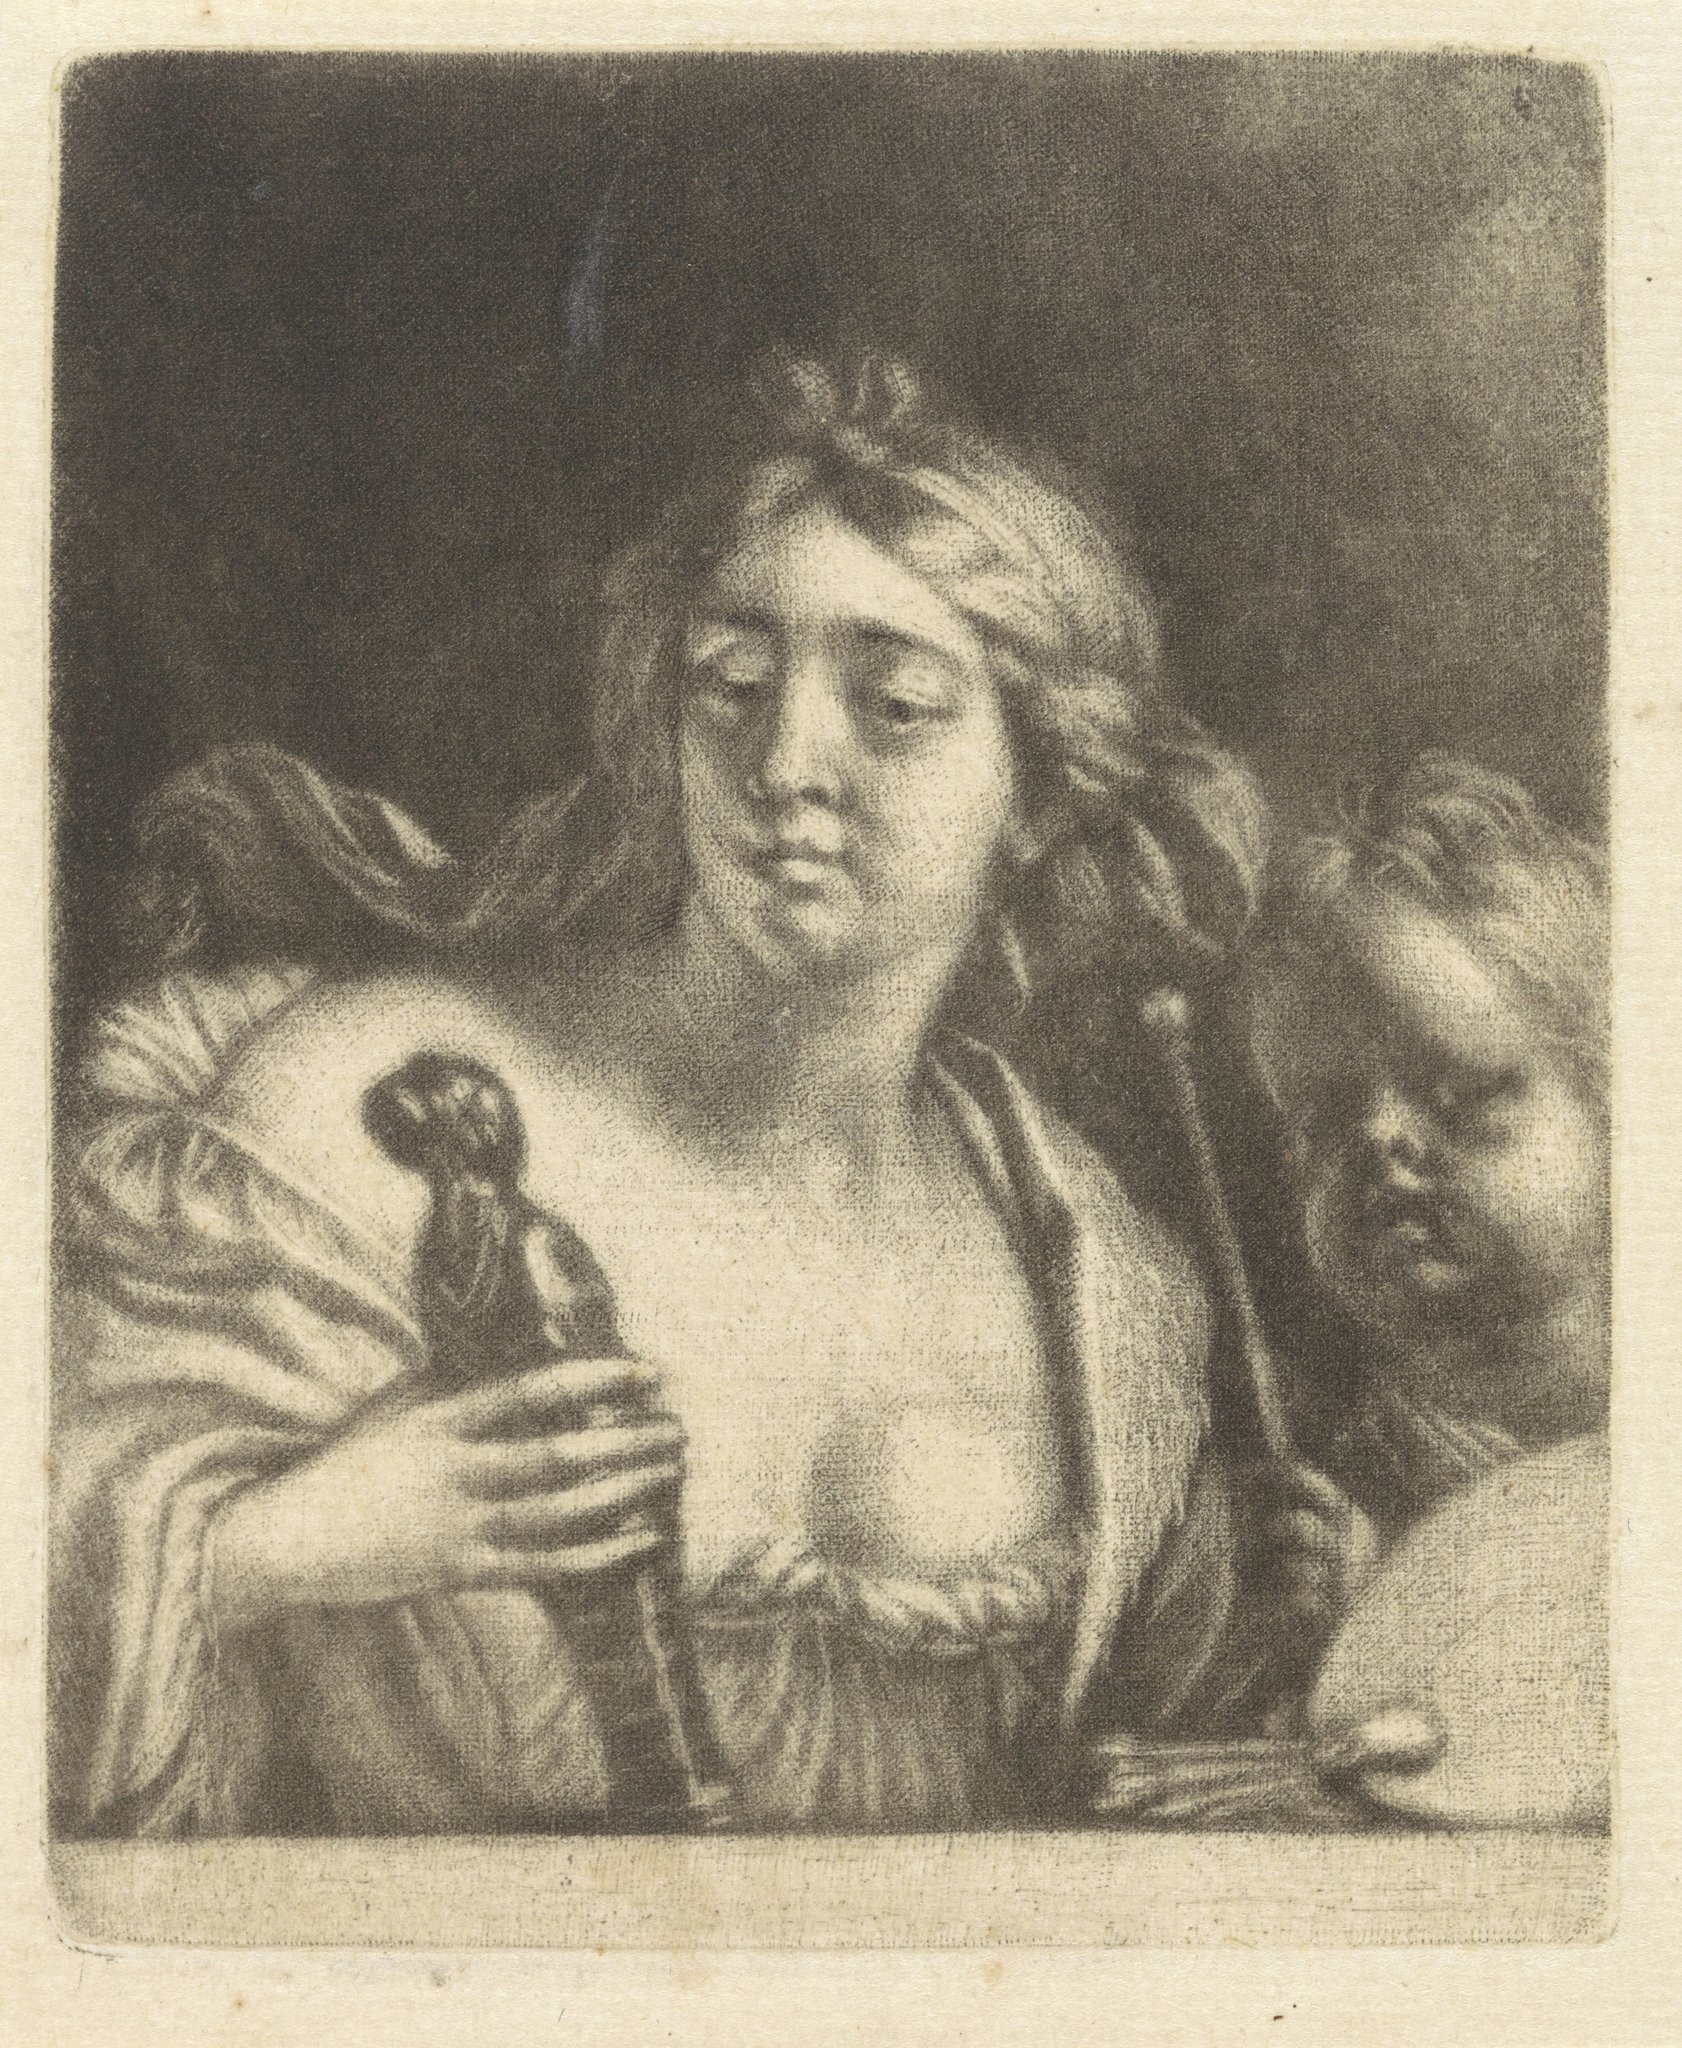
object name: print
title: Allegorie op de Schilderkunst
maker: gerard de lairesse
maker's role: draughtsman, painter, print maker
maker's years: 1641-1711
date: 1670-1680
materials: paper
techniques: mezzotint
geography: amsterdam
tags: 'pictura', symbolic representations, allegories and emblems ~ painting; 'pittura' (ripa), palette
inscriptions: collector's mark: Lugt 2228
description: Een vrouw en een kind met een beeldje en een schilderspalet.